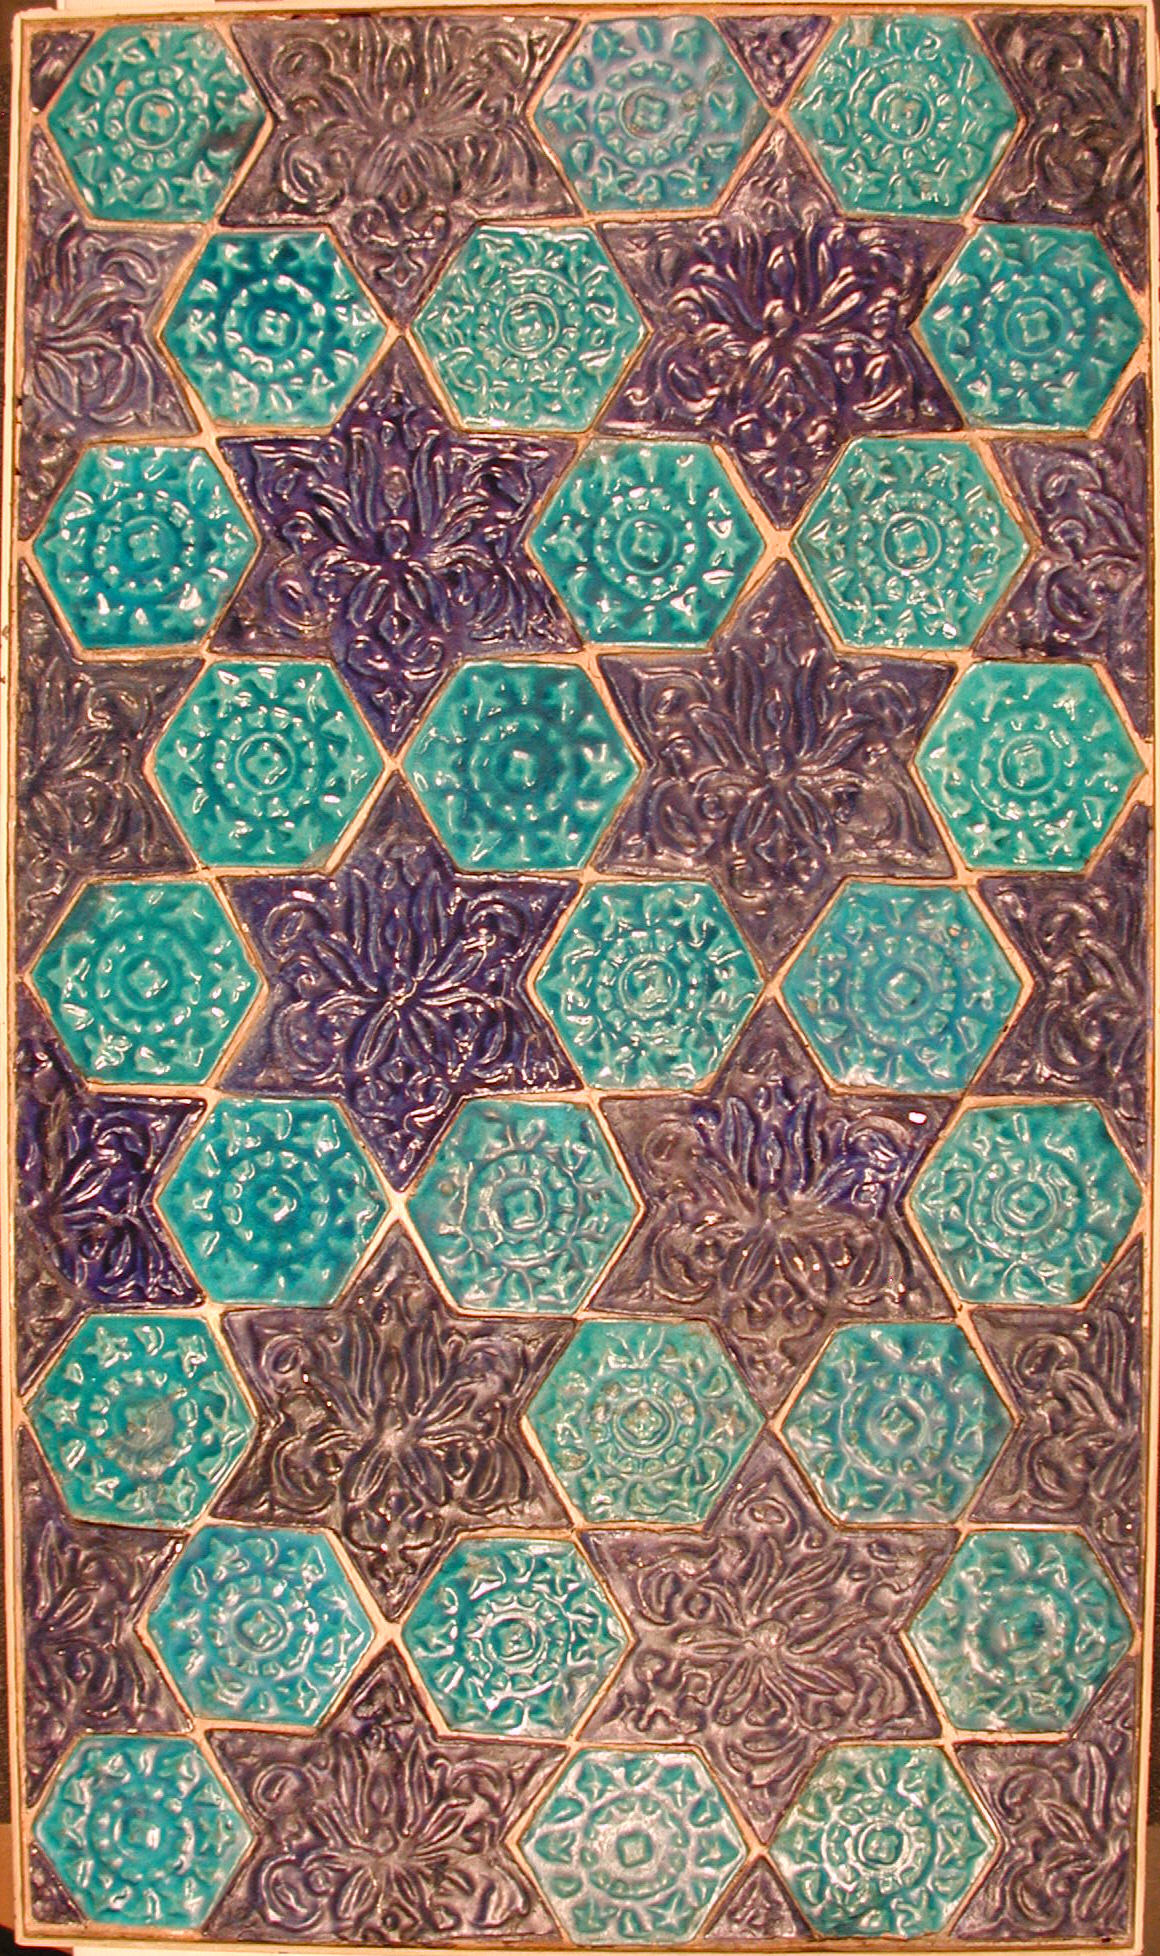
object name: tile panel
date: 1267-1400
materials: glaze, stonepaste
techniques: molding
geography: iran